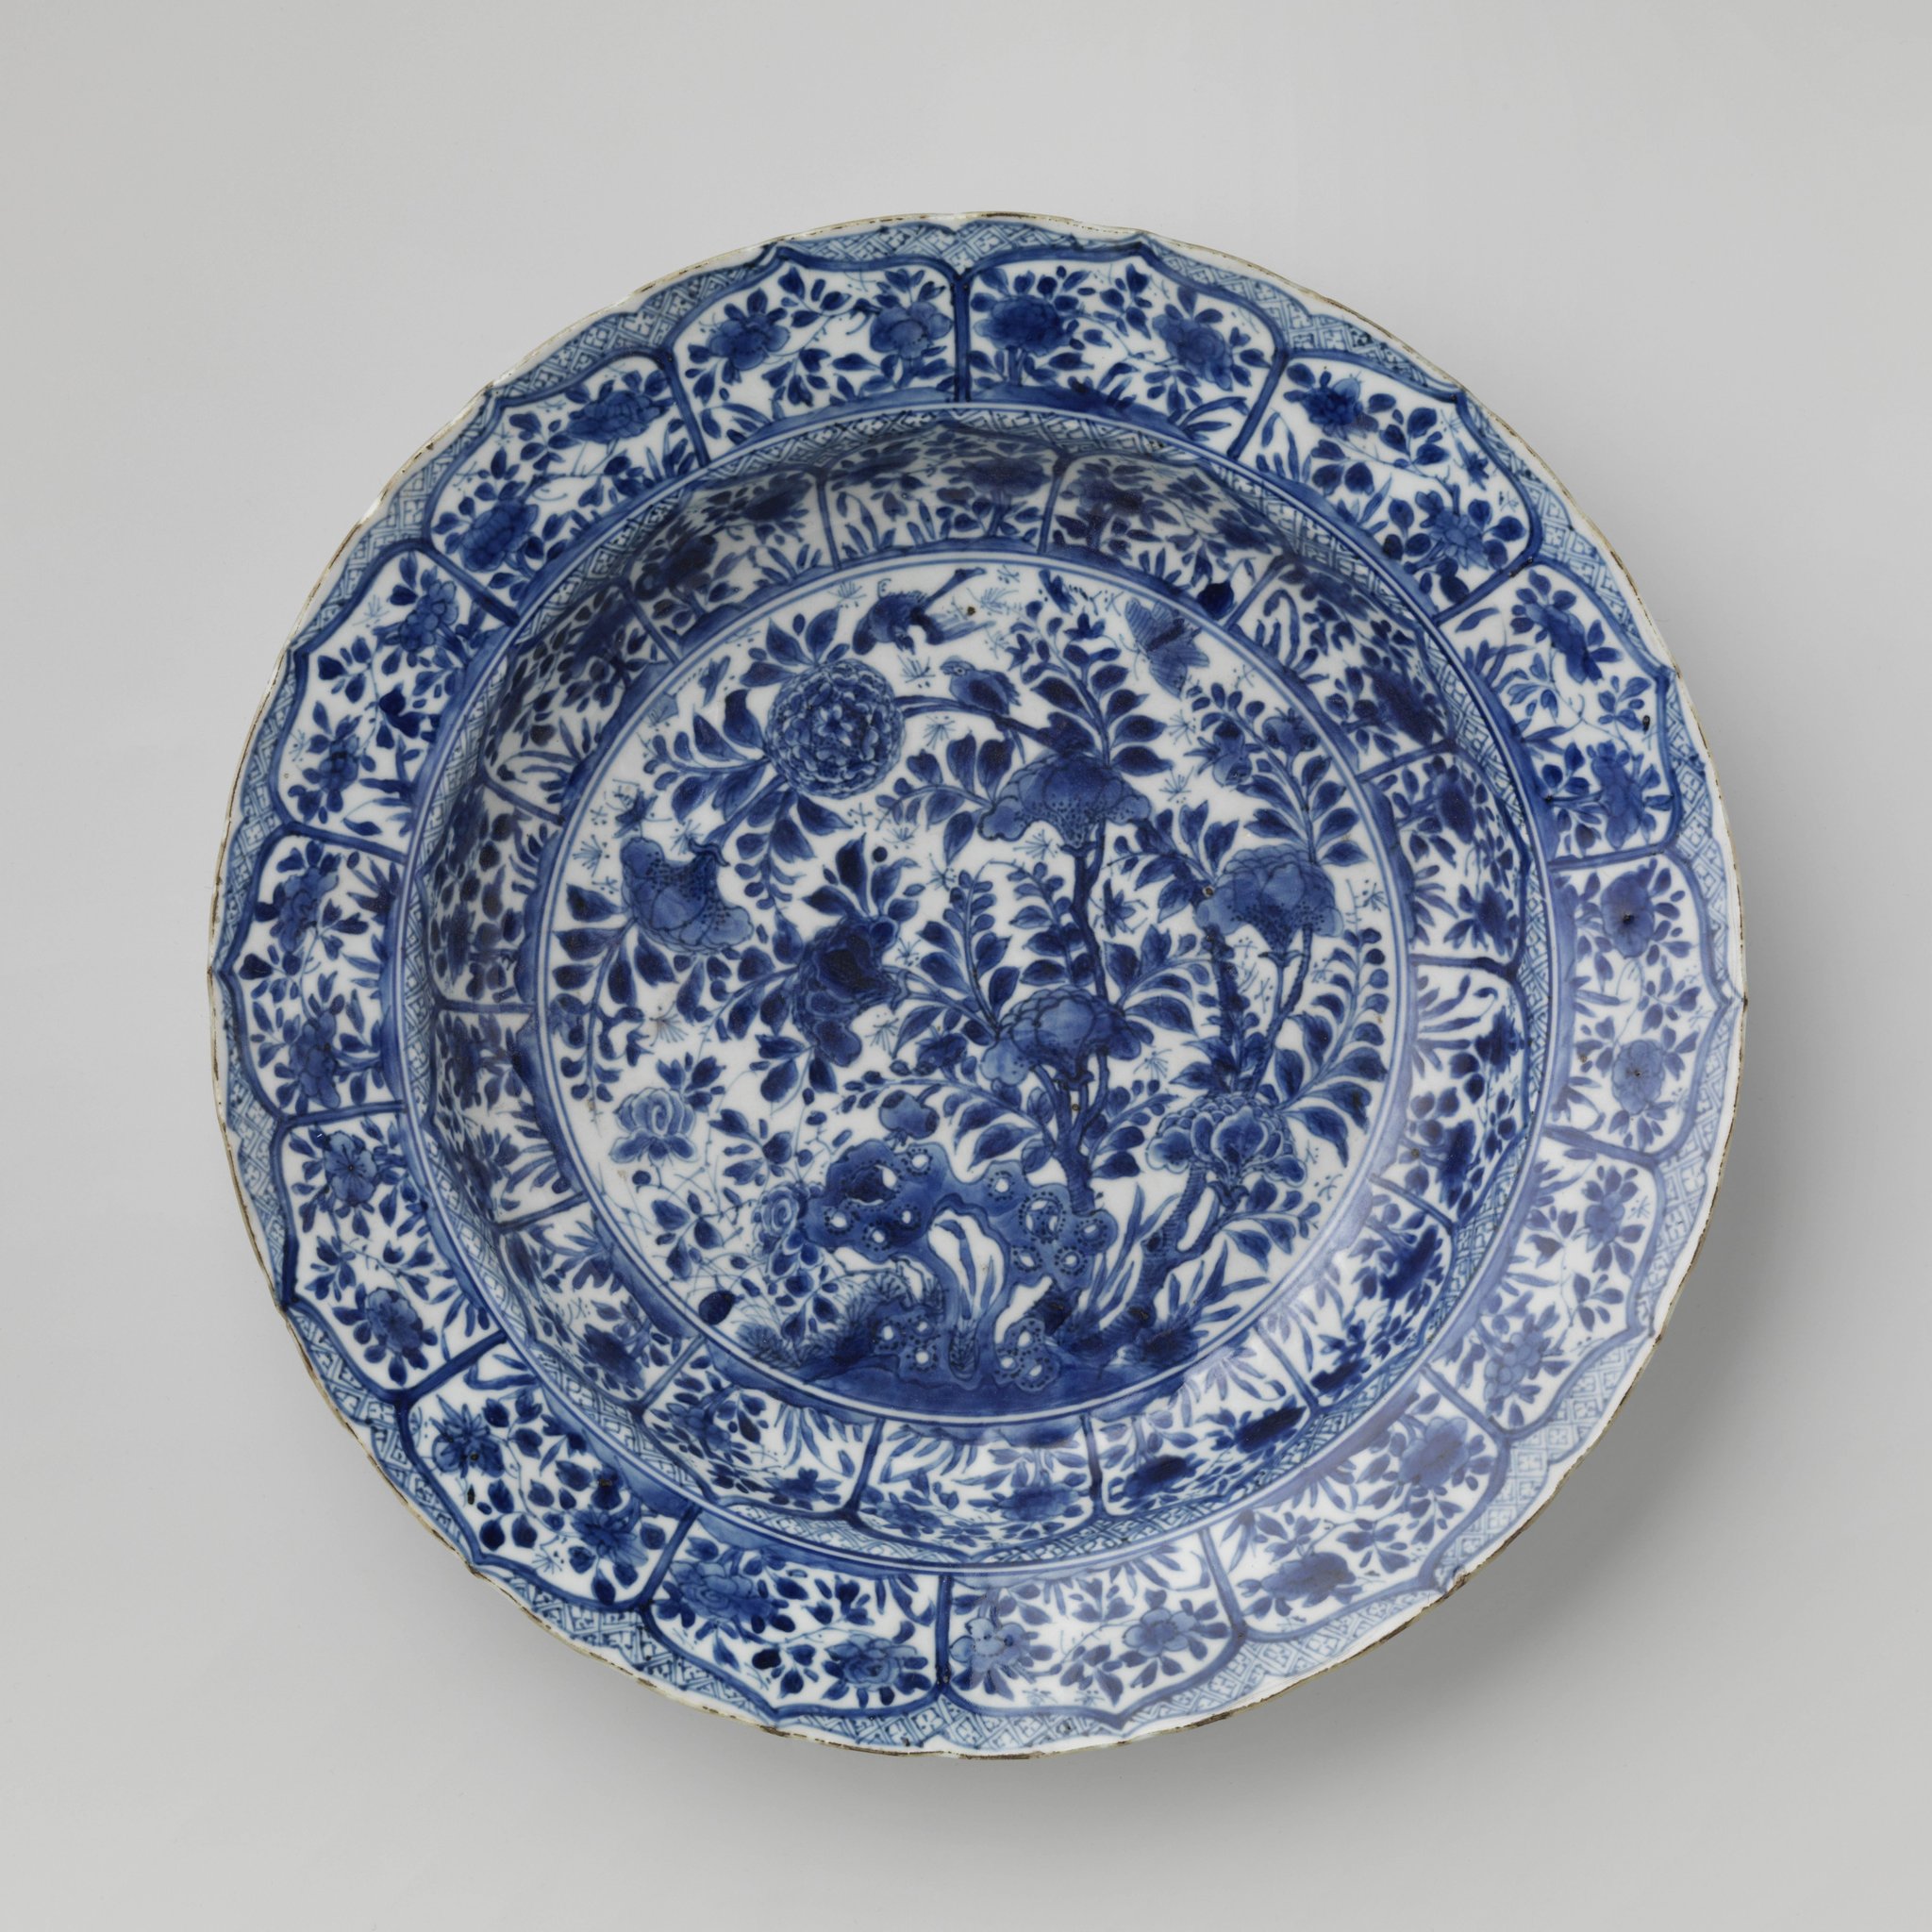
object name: platter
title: Dish with flowering plants in petal-shaped panels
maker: Anonymous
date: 1680-1720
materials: cobalt, glaze, paint, porcelain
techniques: firing, turning, vitrification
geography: china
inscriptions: mark: ‘大 明 成 化 年 製’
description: Schotel van porselein met accoladevormige rand, beschilderd in onderglazuur blauw. Op het plat twee grote planten met vogels en insecten bij een rots. Op de wand een band met bloembladvormige vakken met bloeiende planten tegen een achtergrond van servetwerk. Op de rand dezelfde band. De buitenrand met zes bloemranken. De buitenwand met ruyi-motieven gescheiden door een verticale lijn. Gemerkt op de onderzijde met het zes-karaktermerk van keizer Chenghua in een dubbele cirkel. Blauw-wit.